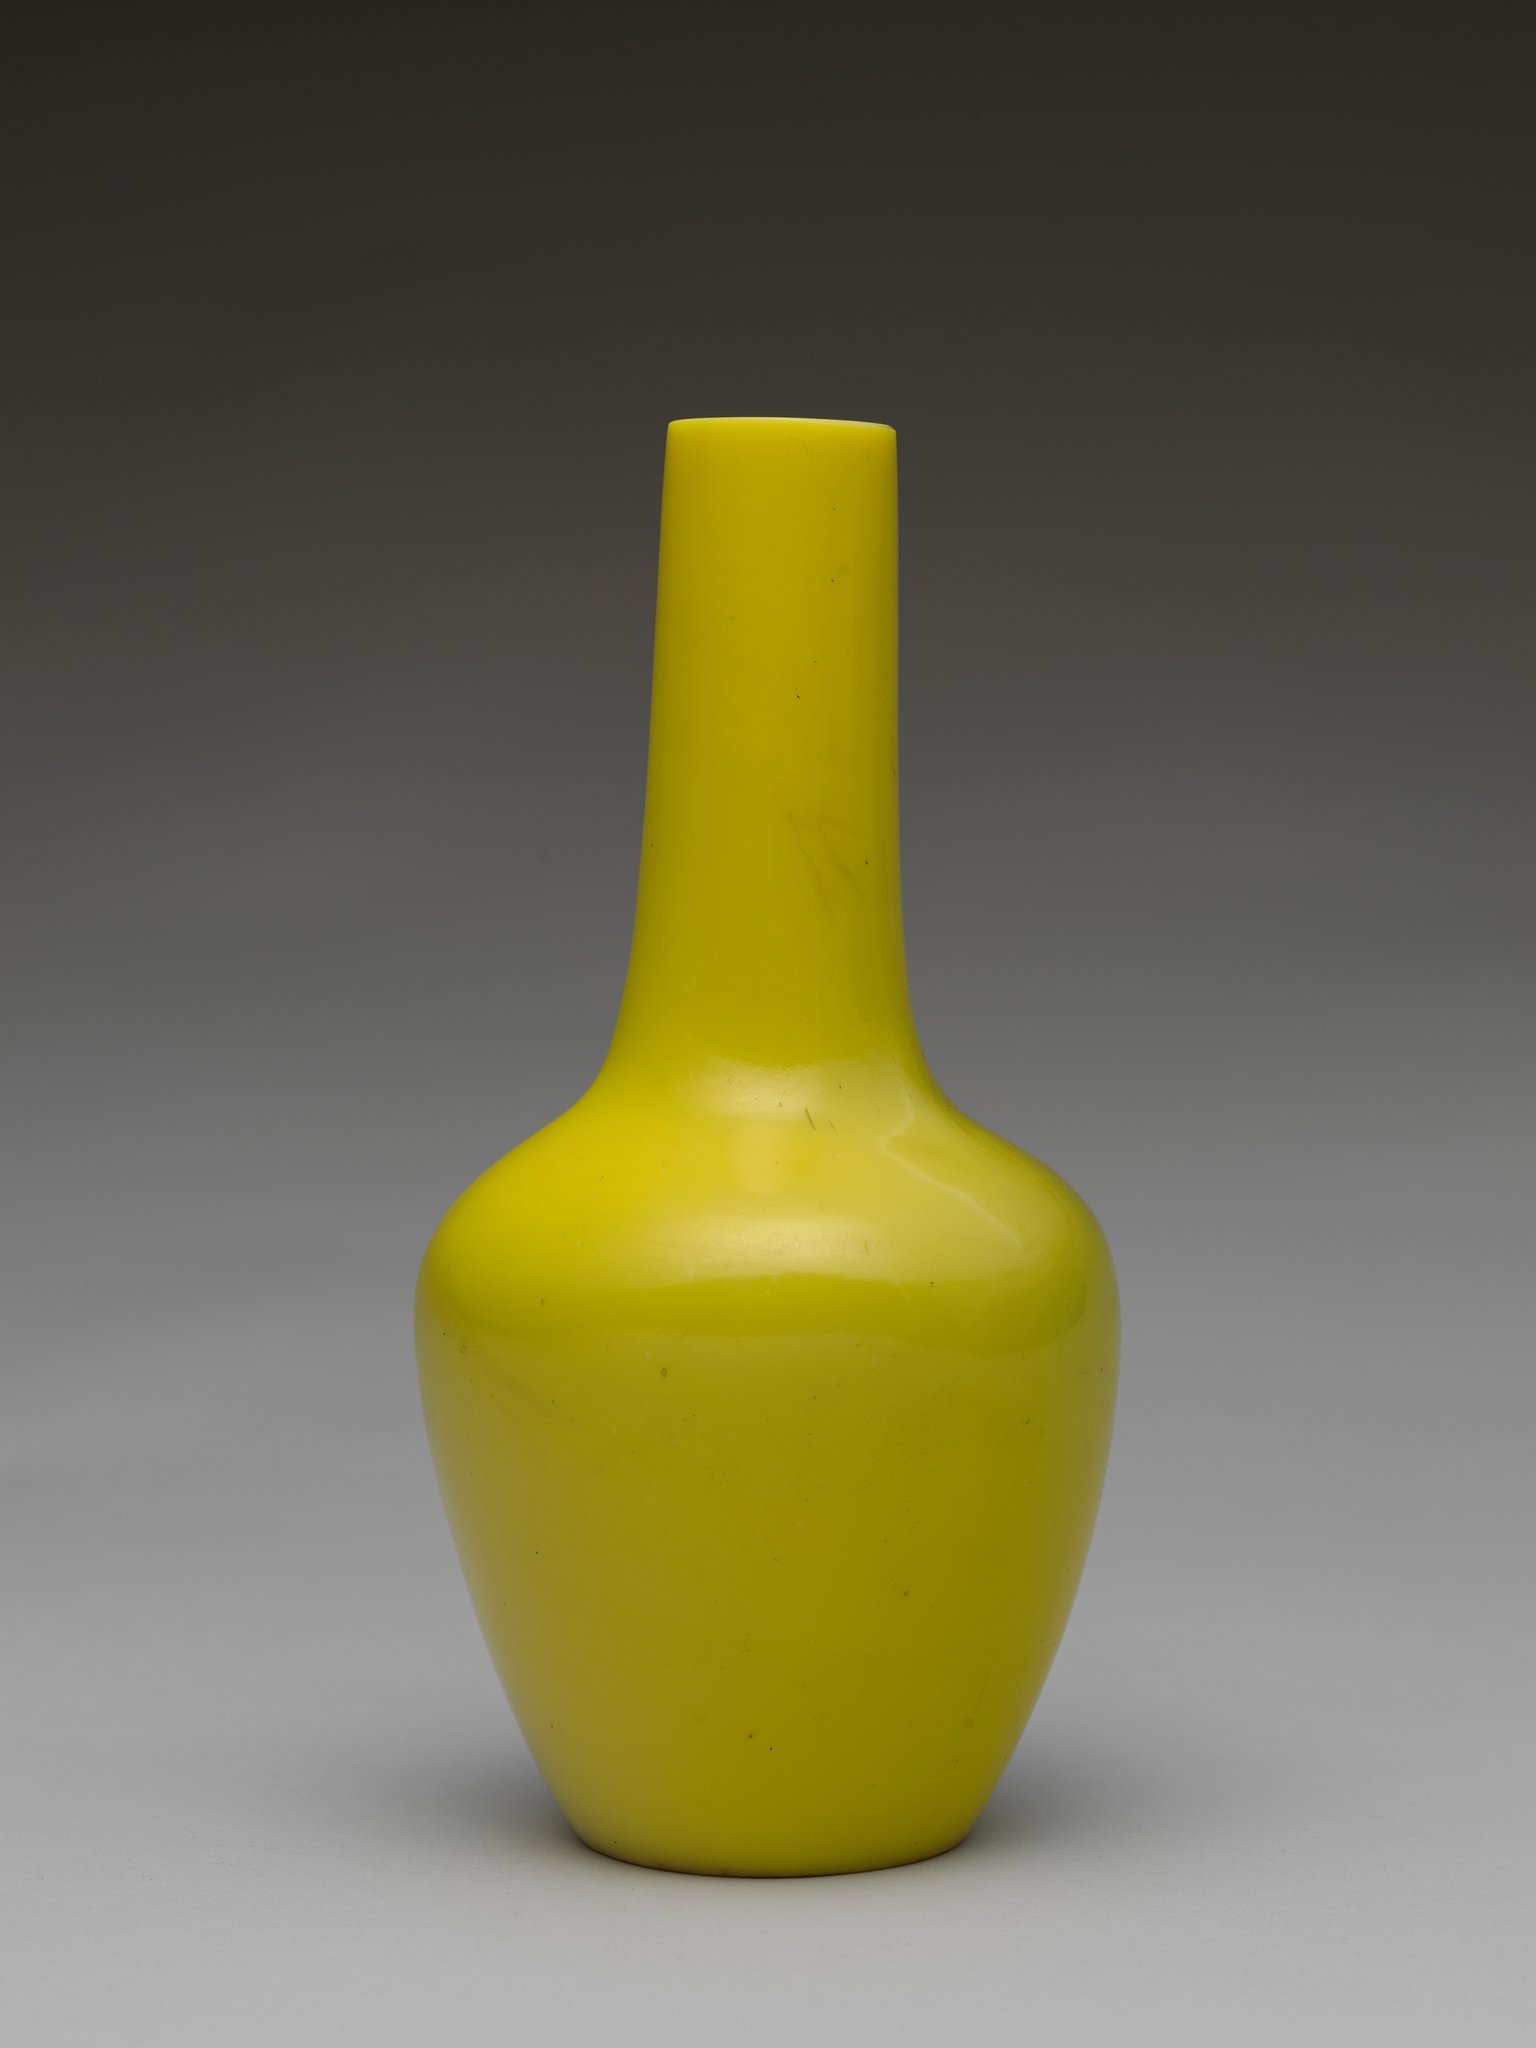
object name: bottle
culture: chinese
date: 1701-1800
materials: glass